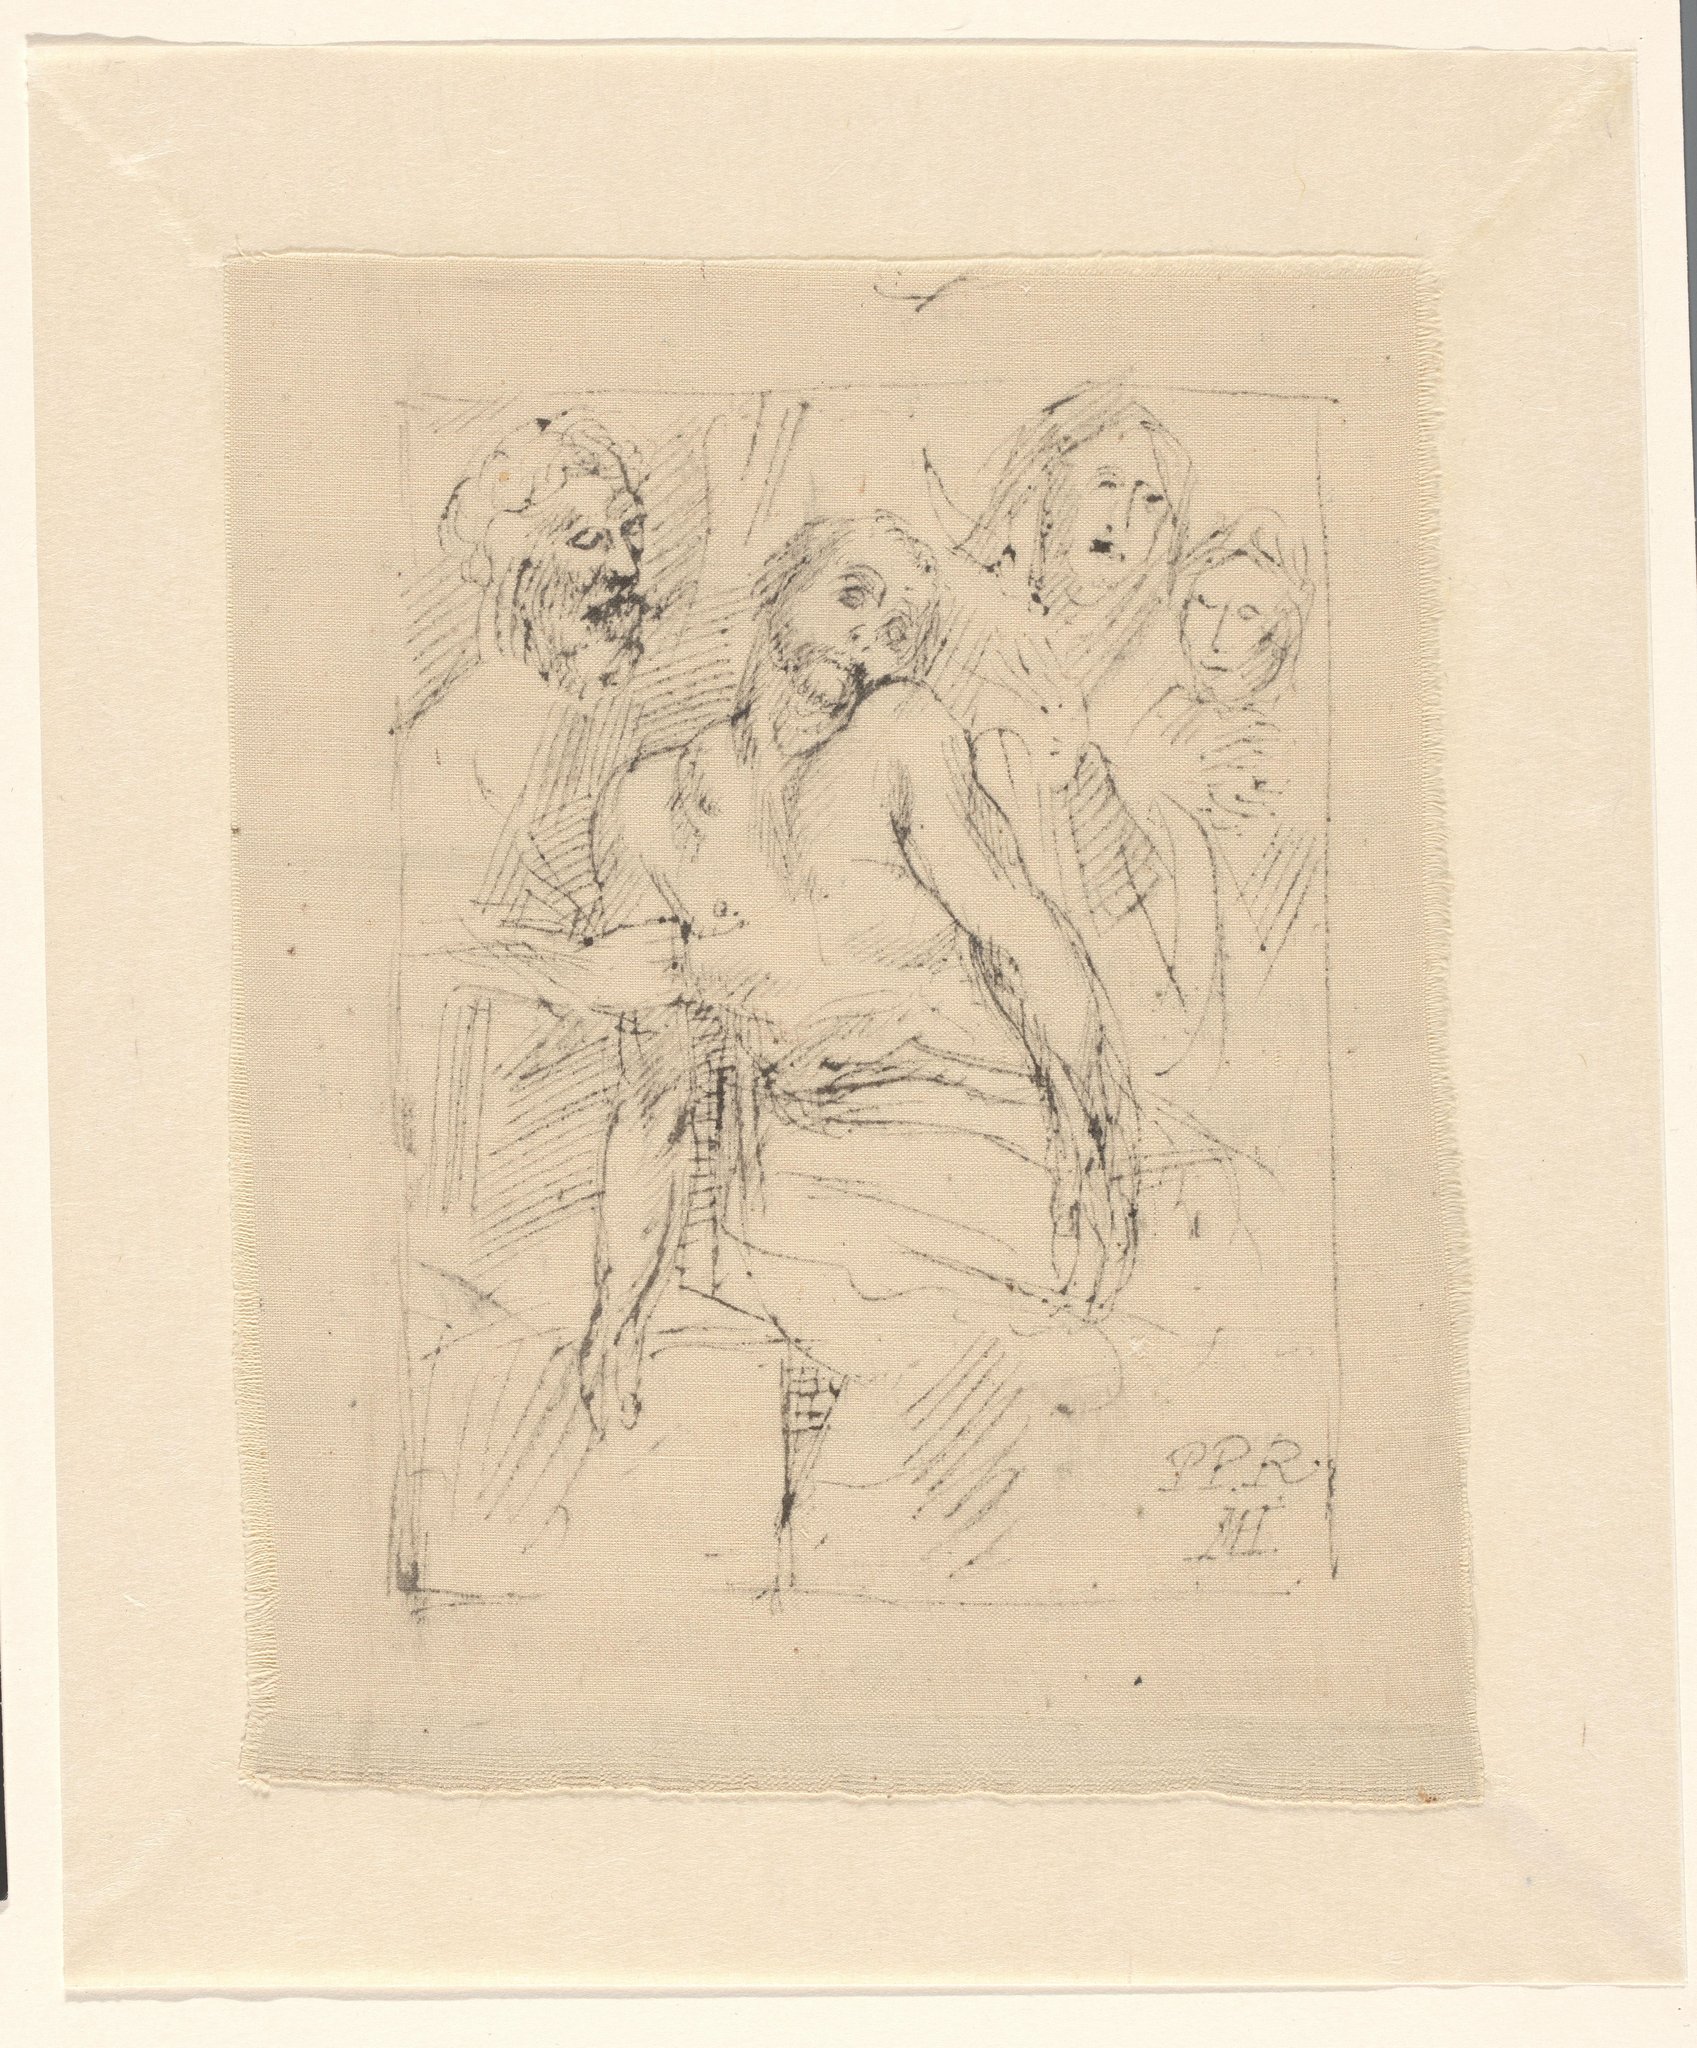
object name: drawing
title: Bewening van Christus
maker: marius holleman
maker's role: draughtsman, print maker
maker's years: 1878-1926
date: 1888-1926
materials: ink, linen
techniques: pen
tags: lamentation over the dead christ by his relatives and friends (christ usually without crown of thorns)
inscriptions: inscription: ‘PP.R.’